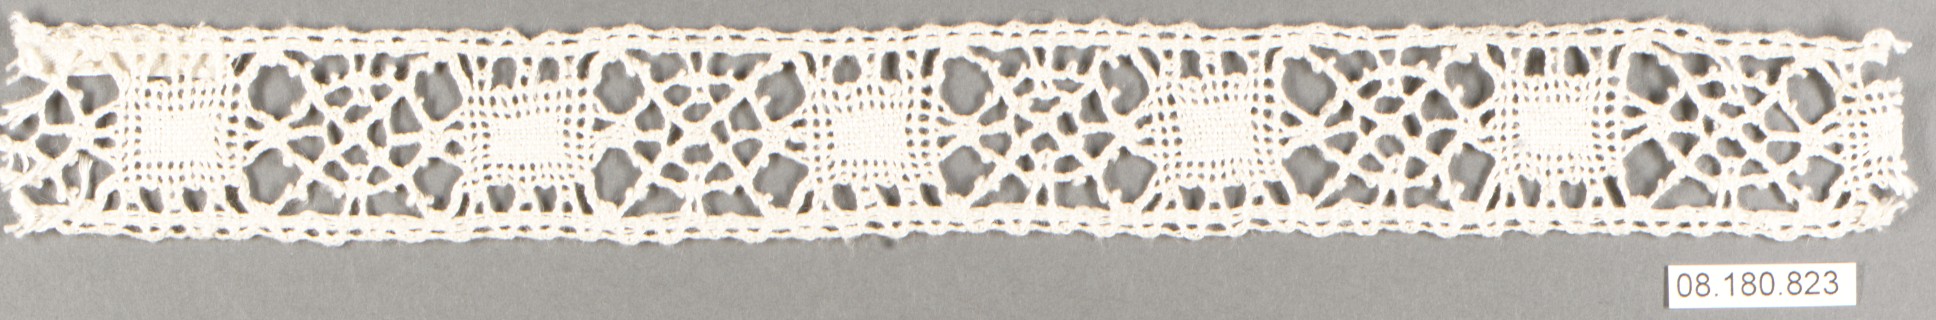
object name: insertion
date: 1801-1900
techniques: lace